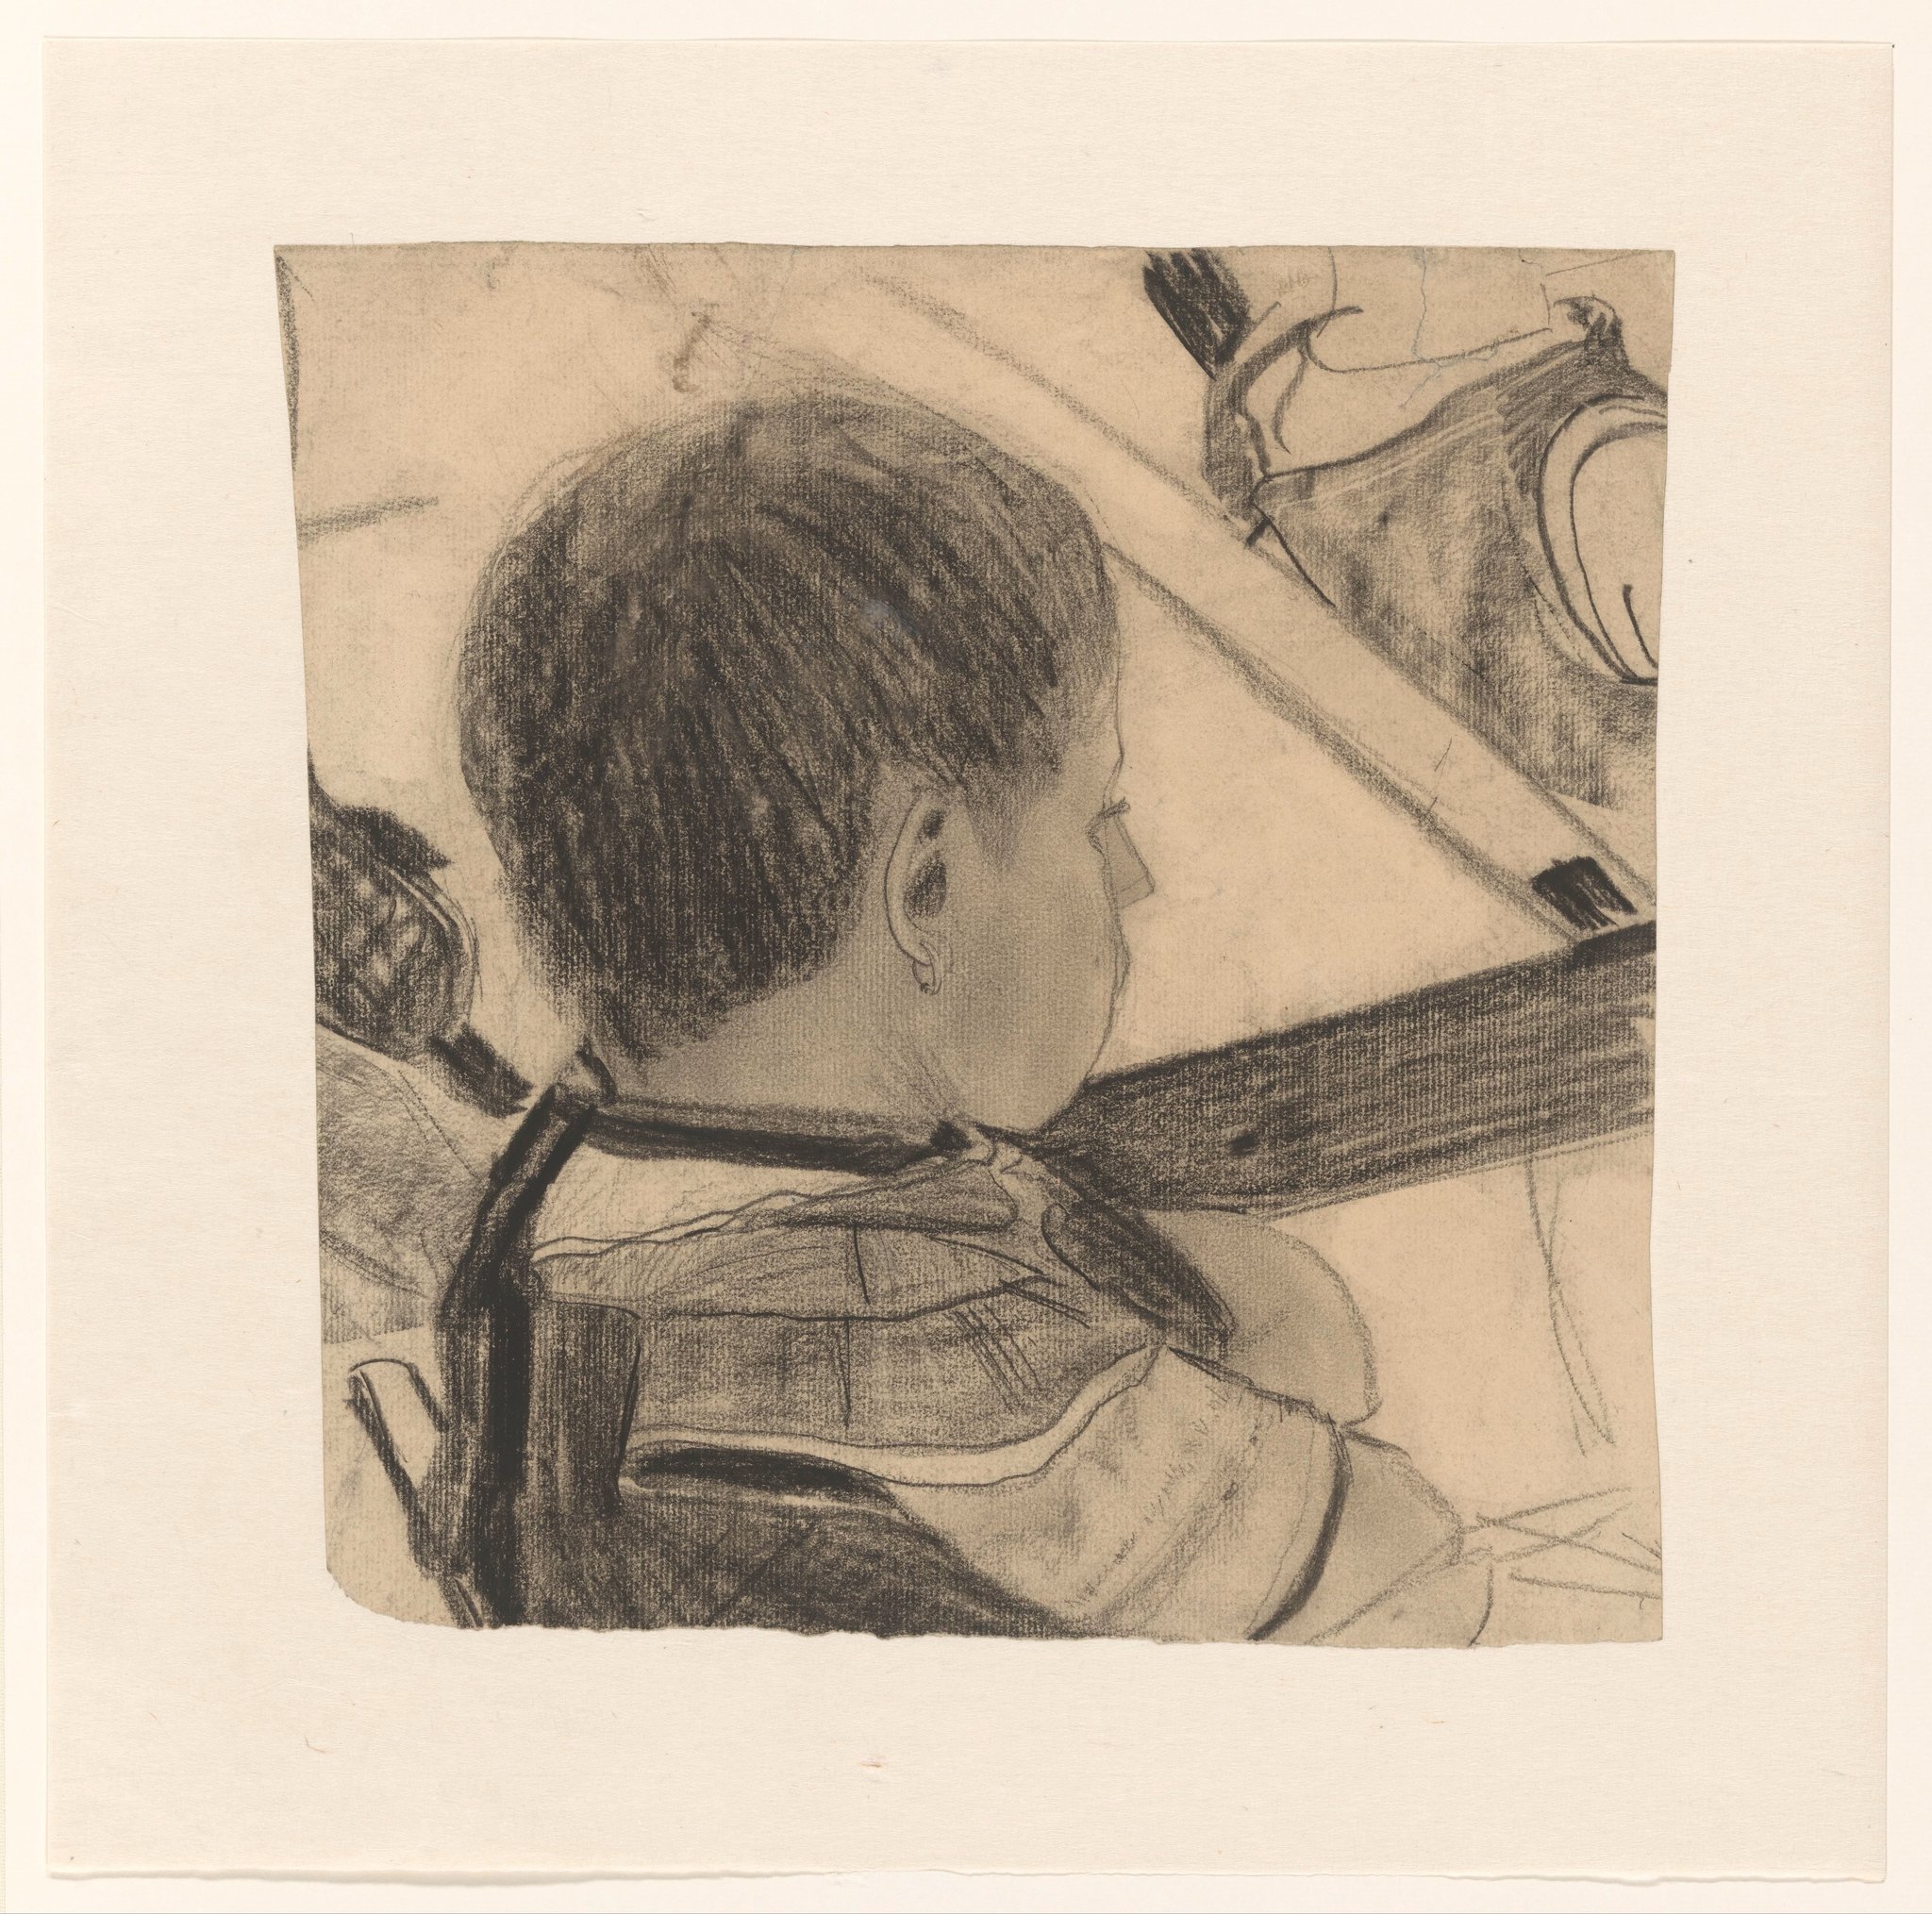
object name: drawing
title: Schoolkind, gezien van schuin achter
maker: carel adolph lion cachet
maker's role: draughtsman, print maker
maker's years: 1864-1945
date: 1874-1945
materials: chalk, paper